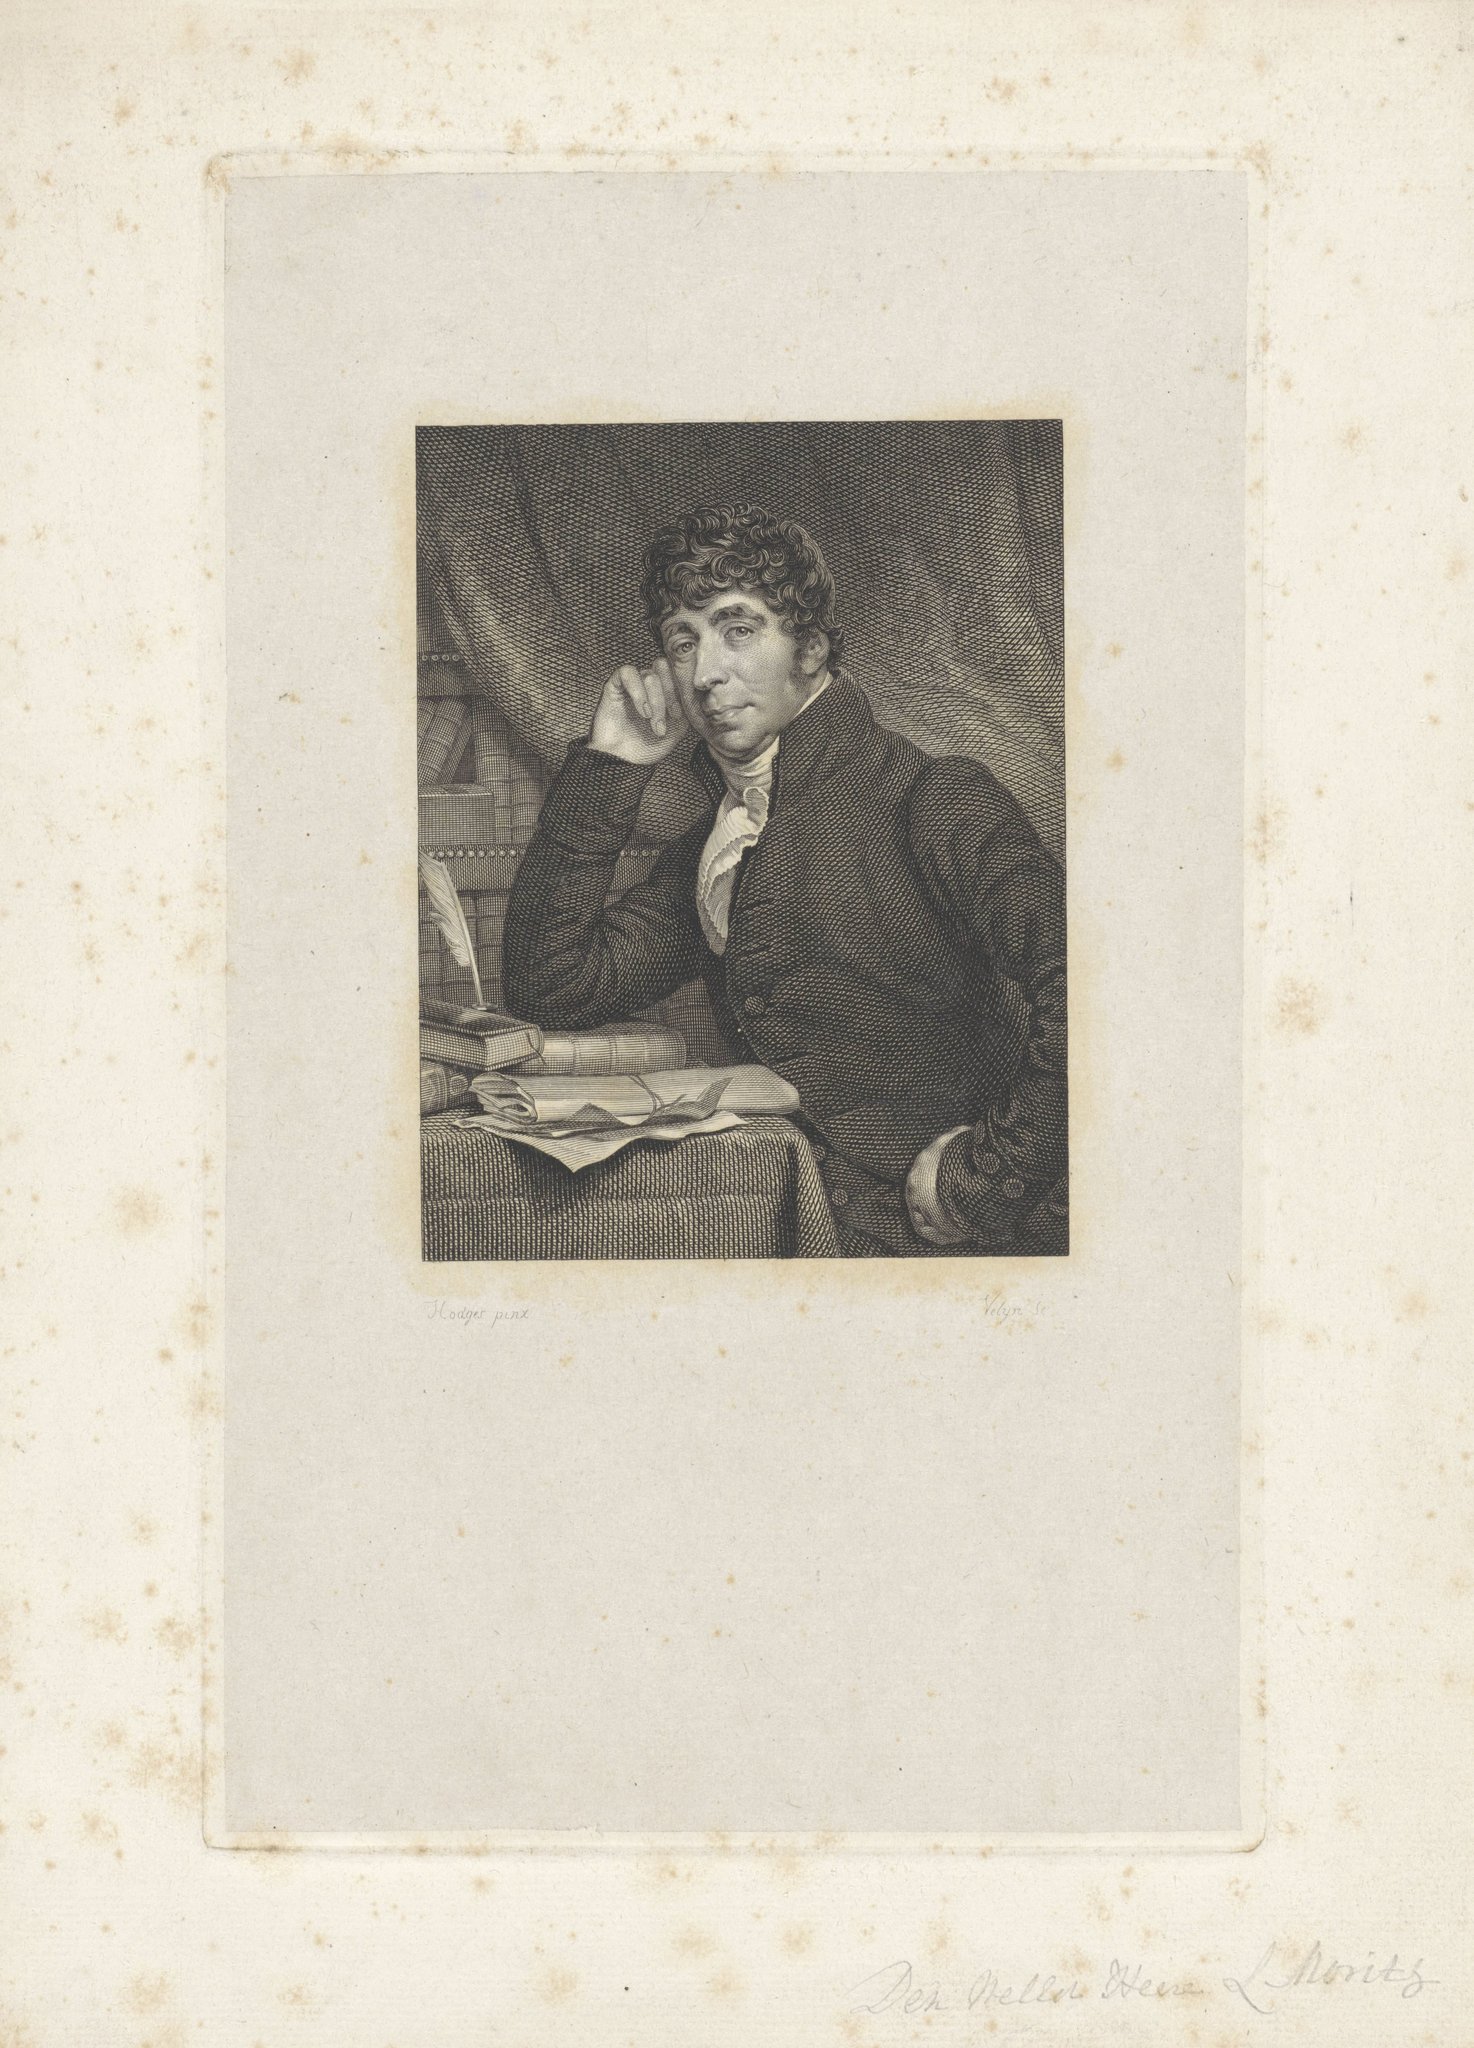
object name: print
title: Portret van Willem Bilderdijk aan zijn schrijftafel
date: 1797-1836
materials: paper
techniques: engraving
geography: netherlands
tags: amsterdam, haarlem, print maker, draughtsman, willem bilderdijk, quill, study; 'studiolo'; library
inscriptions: collector's mark: Lugt 2228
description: Portret van de geschiedschrijver en dichter Willem Bilderdijk. Zijn elleboog leunt op de tafel voor hem, waarop boeken, papier en een schrijfveer.